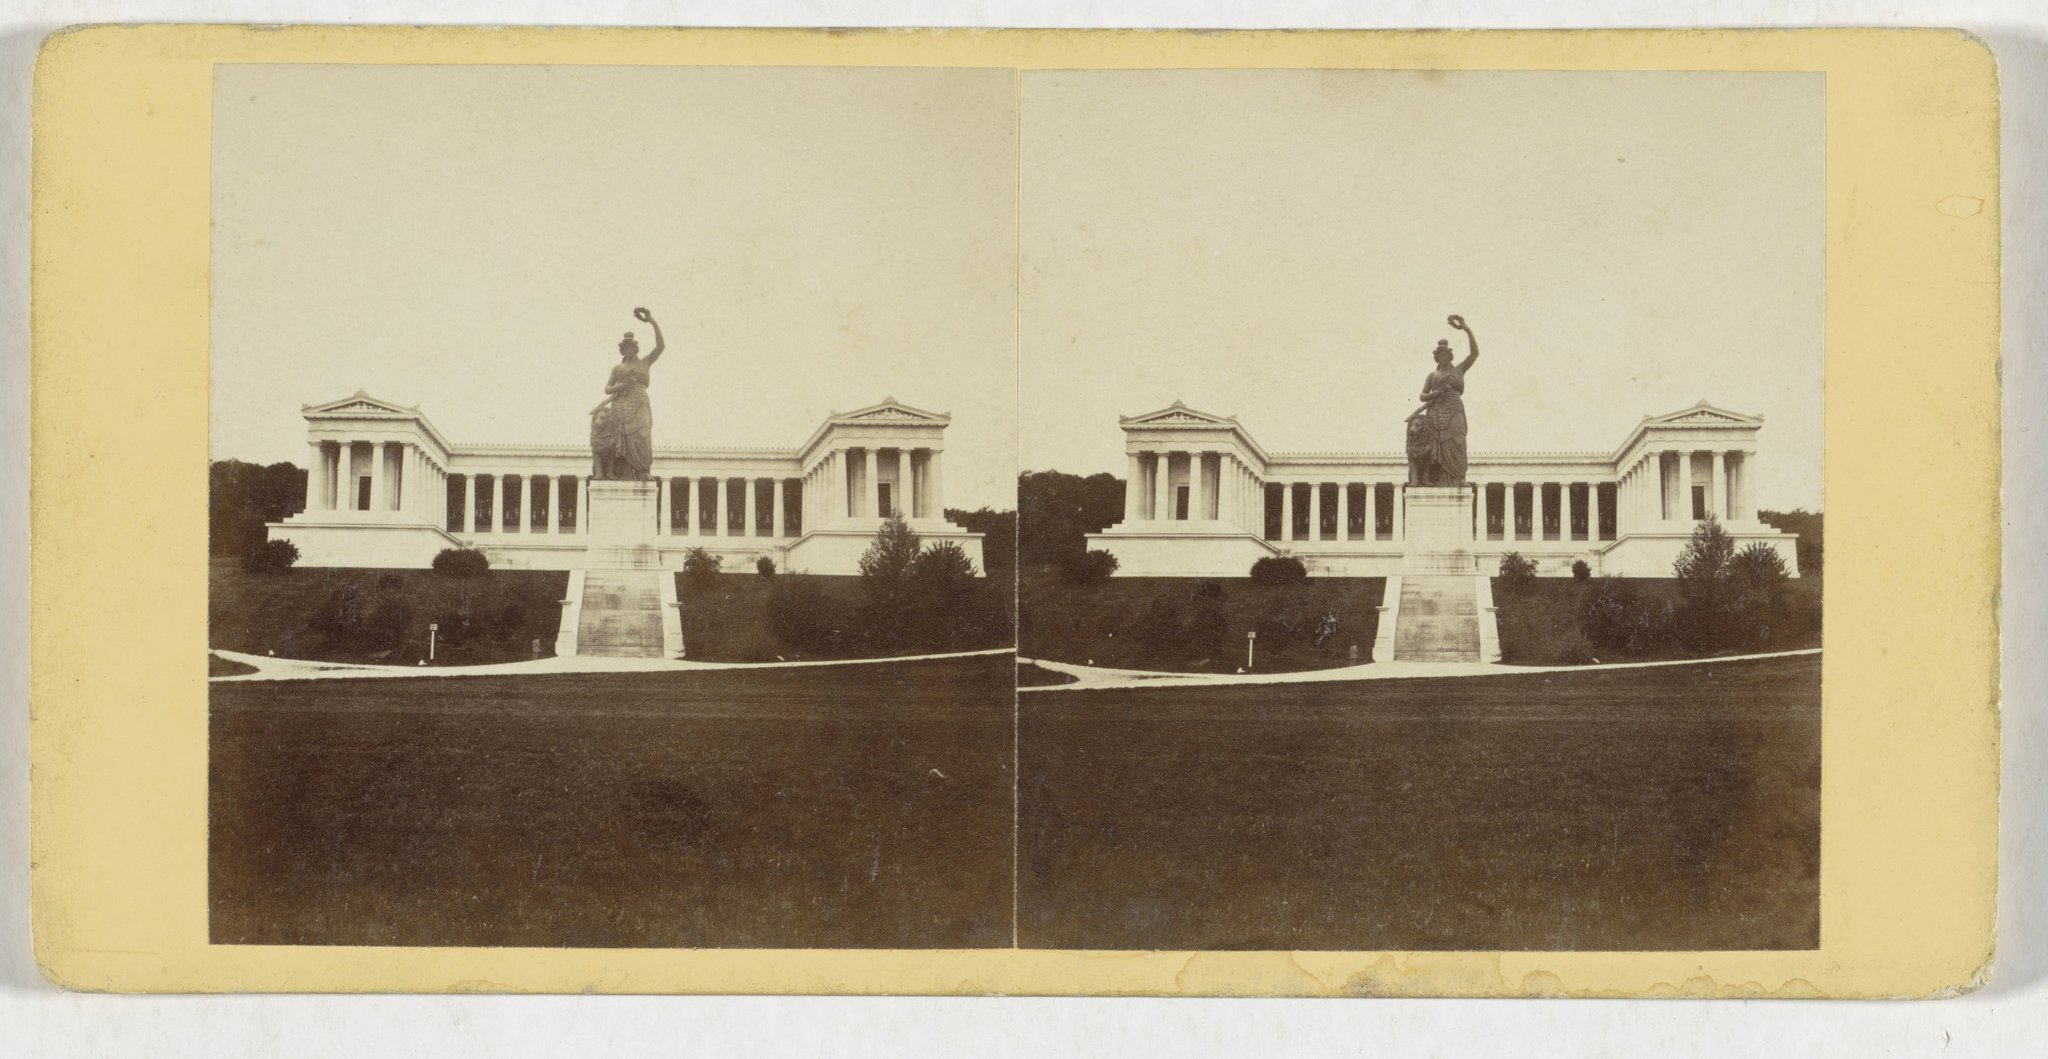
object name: stereograph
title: München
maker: johann friedrich stiehm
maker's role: fotograaf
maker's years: 1826-1902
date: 1868-1890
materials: cardboard, paper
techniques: albumen print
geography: london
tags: doric order ~ architecture, monument, statue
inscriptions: number: ‘No. 1.’